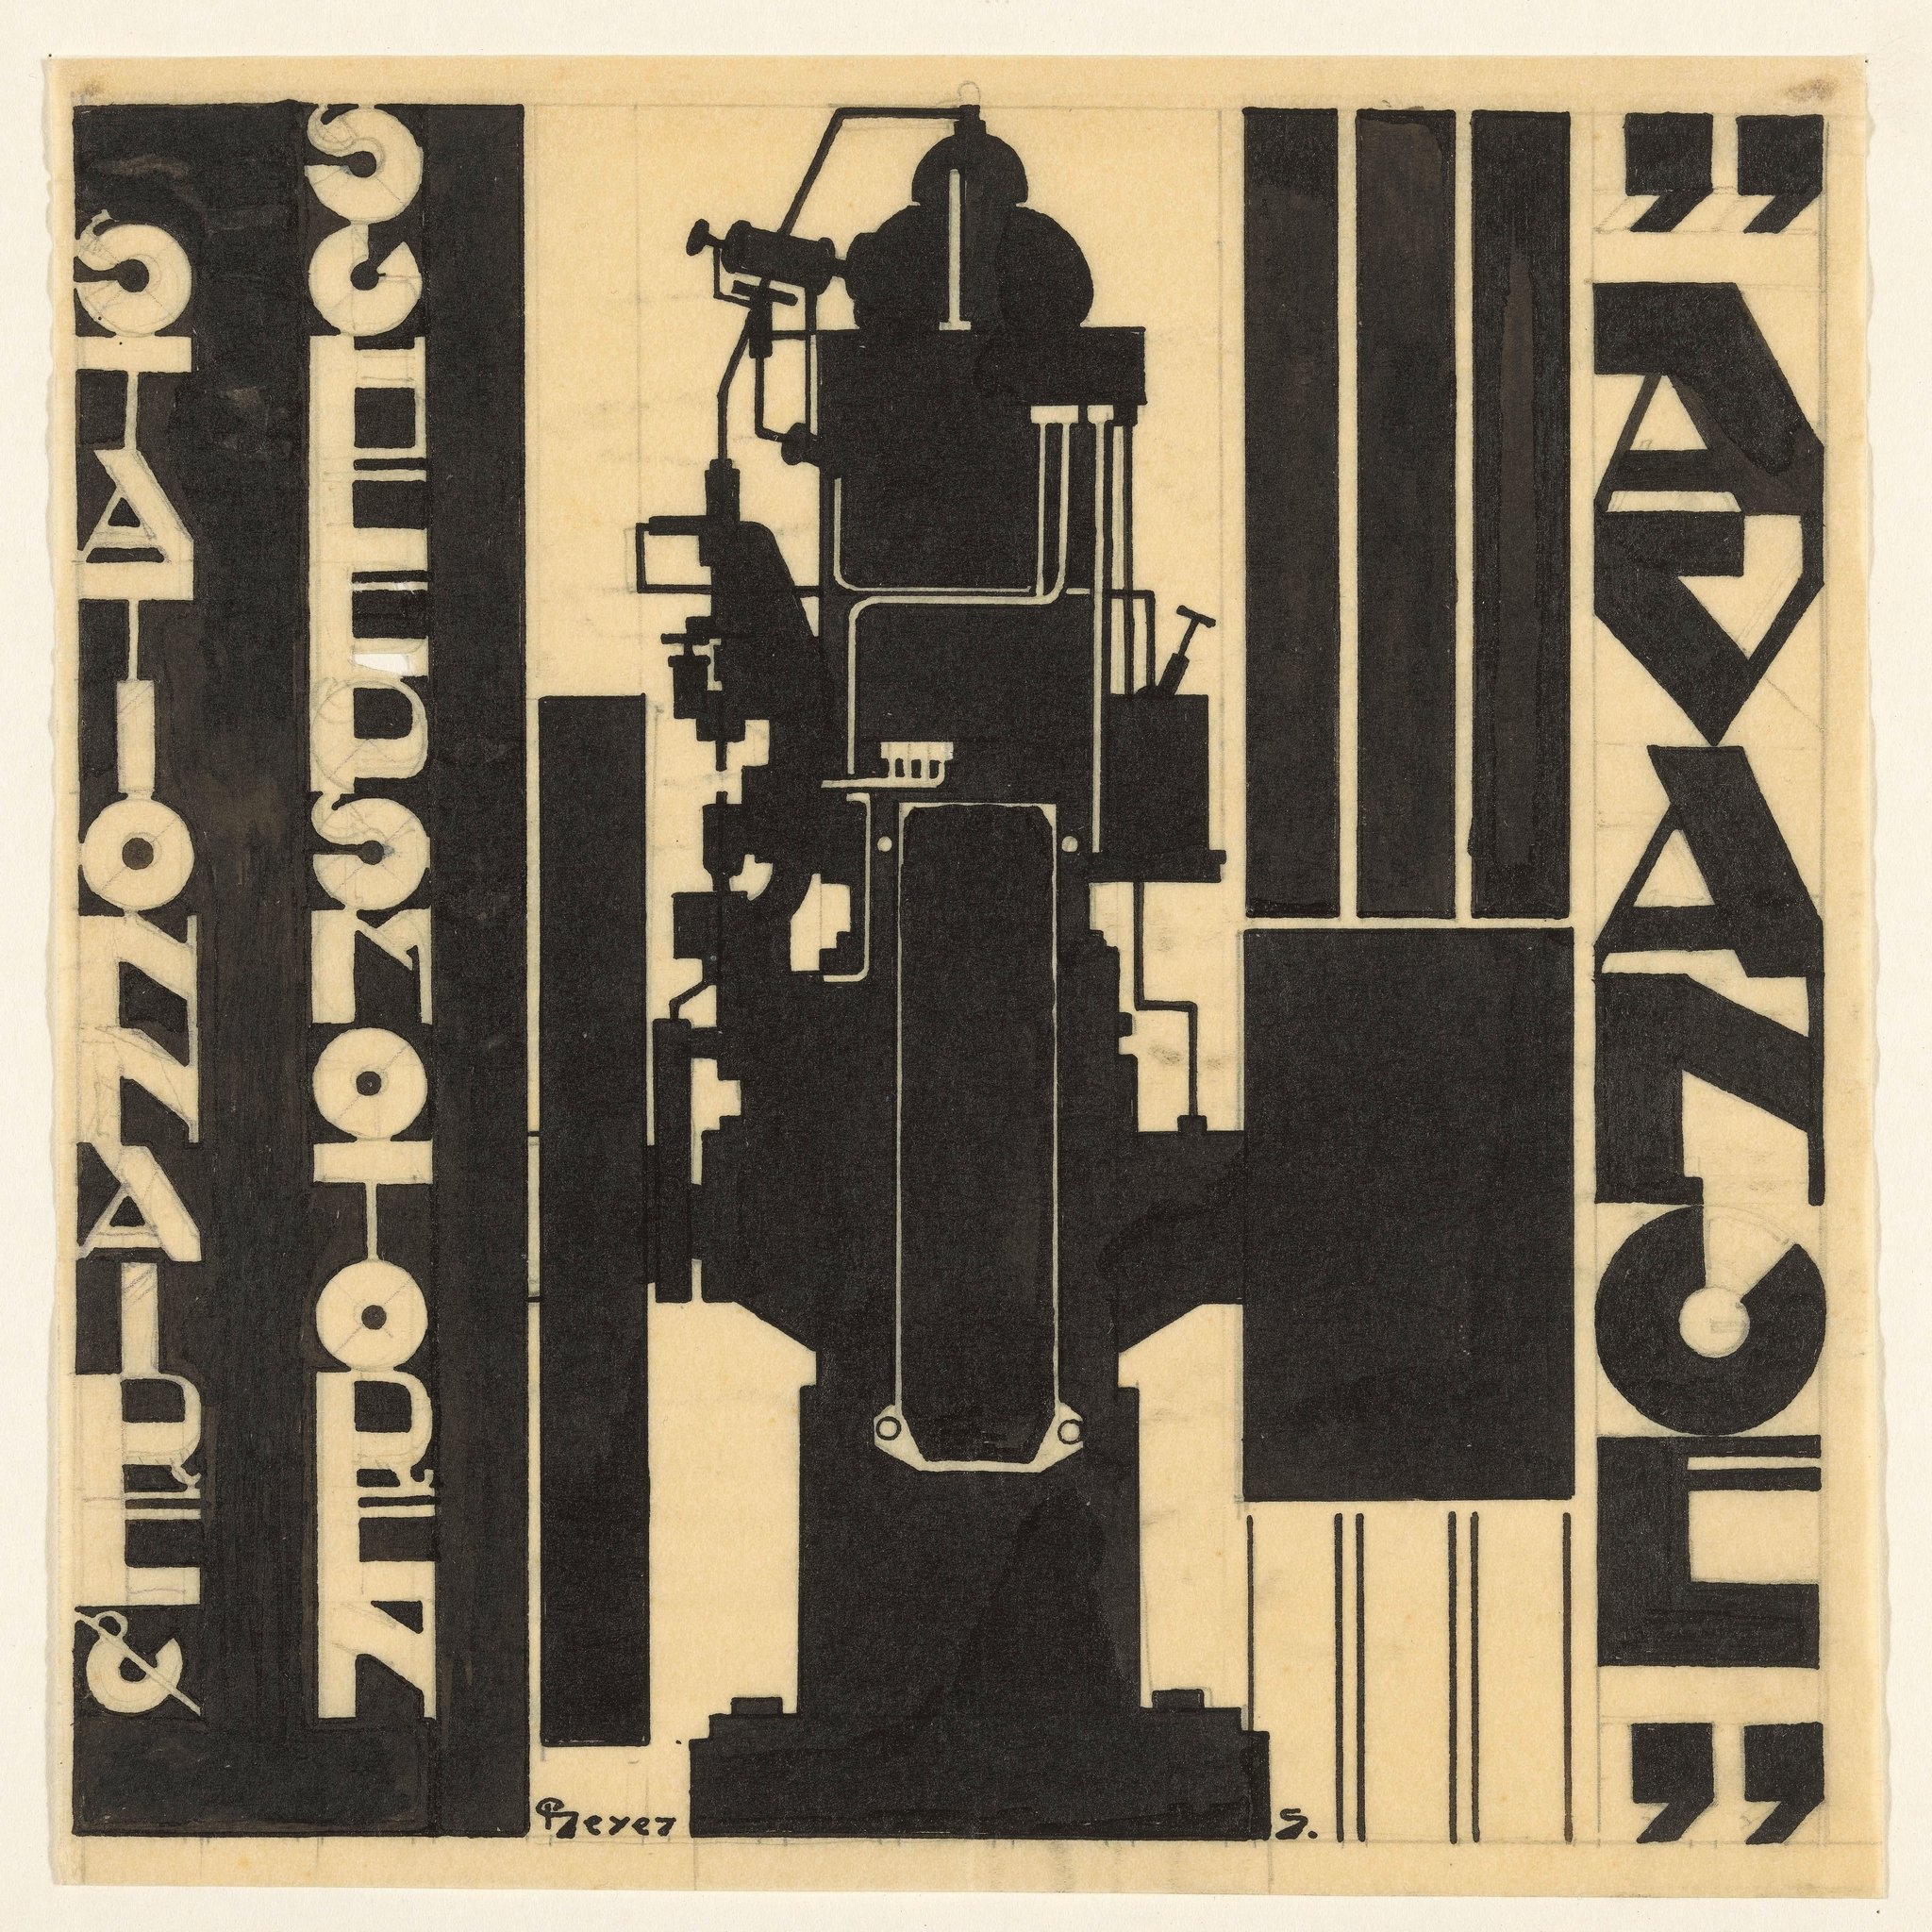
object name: drawing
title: "Avance" stationnaire & scheepsmotoren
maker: reijer stolk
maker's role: draughtsman, print maker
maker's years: 1896-1945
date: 1906-1945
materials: ink, pencil, paper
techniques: brush, pen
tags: advertisement, notice, industries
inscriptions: collector's mark: Lugt 2760, collector's mark: Lugt 2228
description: Deze tekening is mogelijk een ontwerp voor een advertentie voor Avance stationnaire en scheepsmotoren van AB J.V.Svensons Motorfabrik.